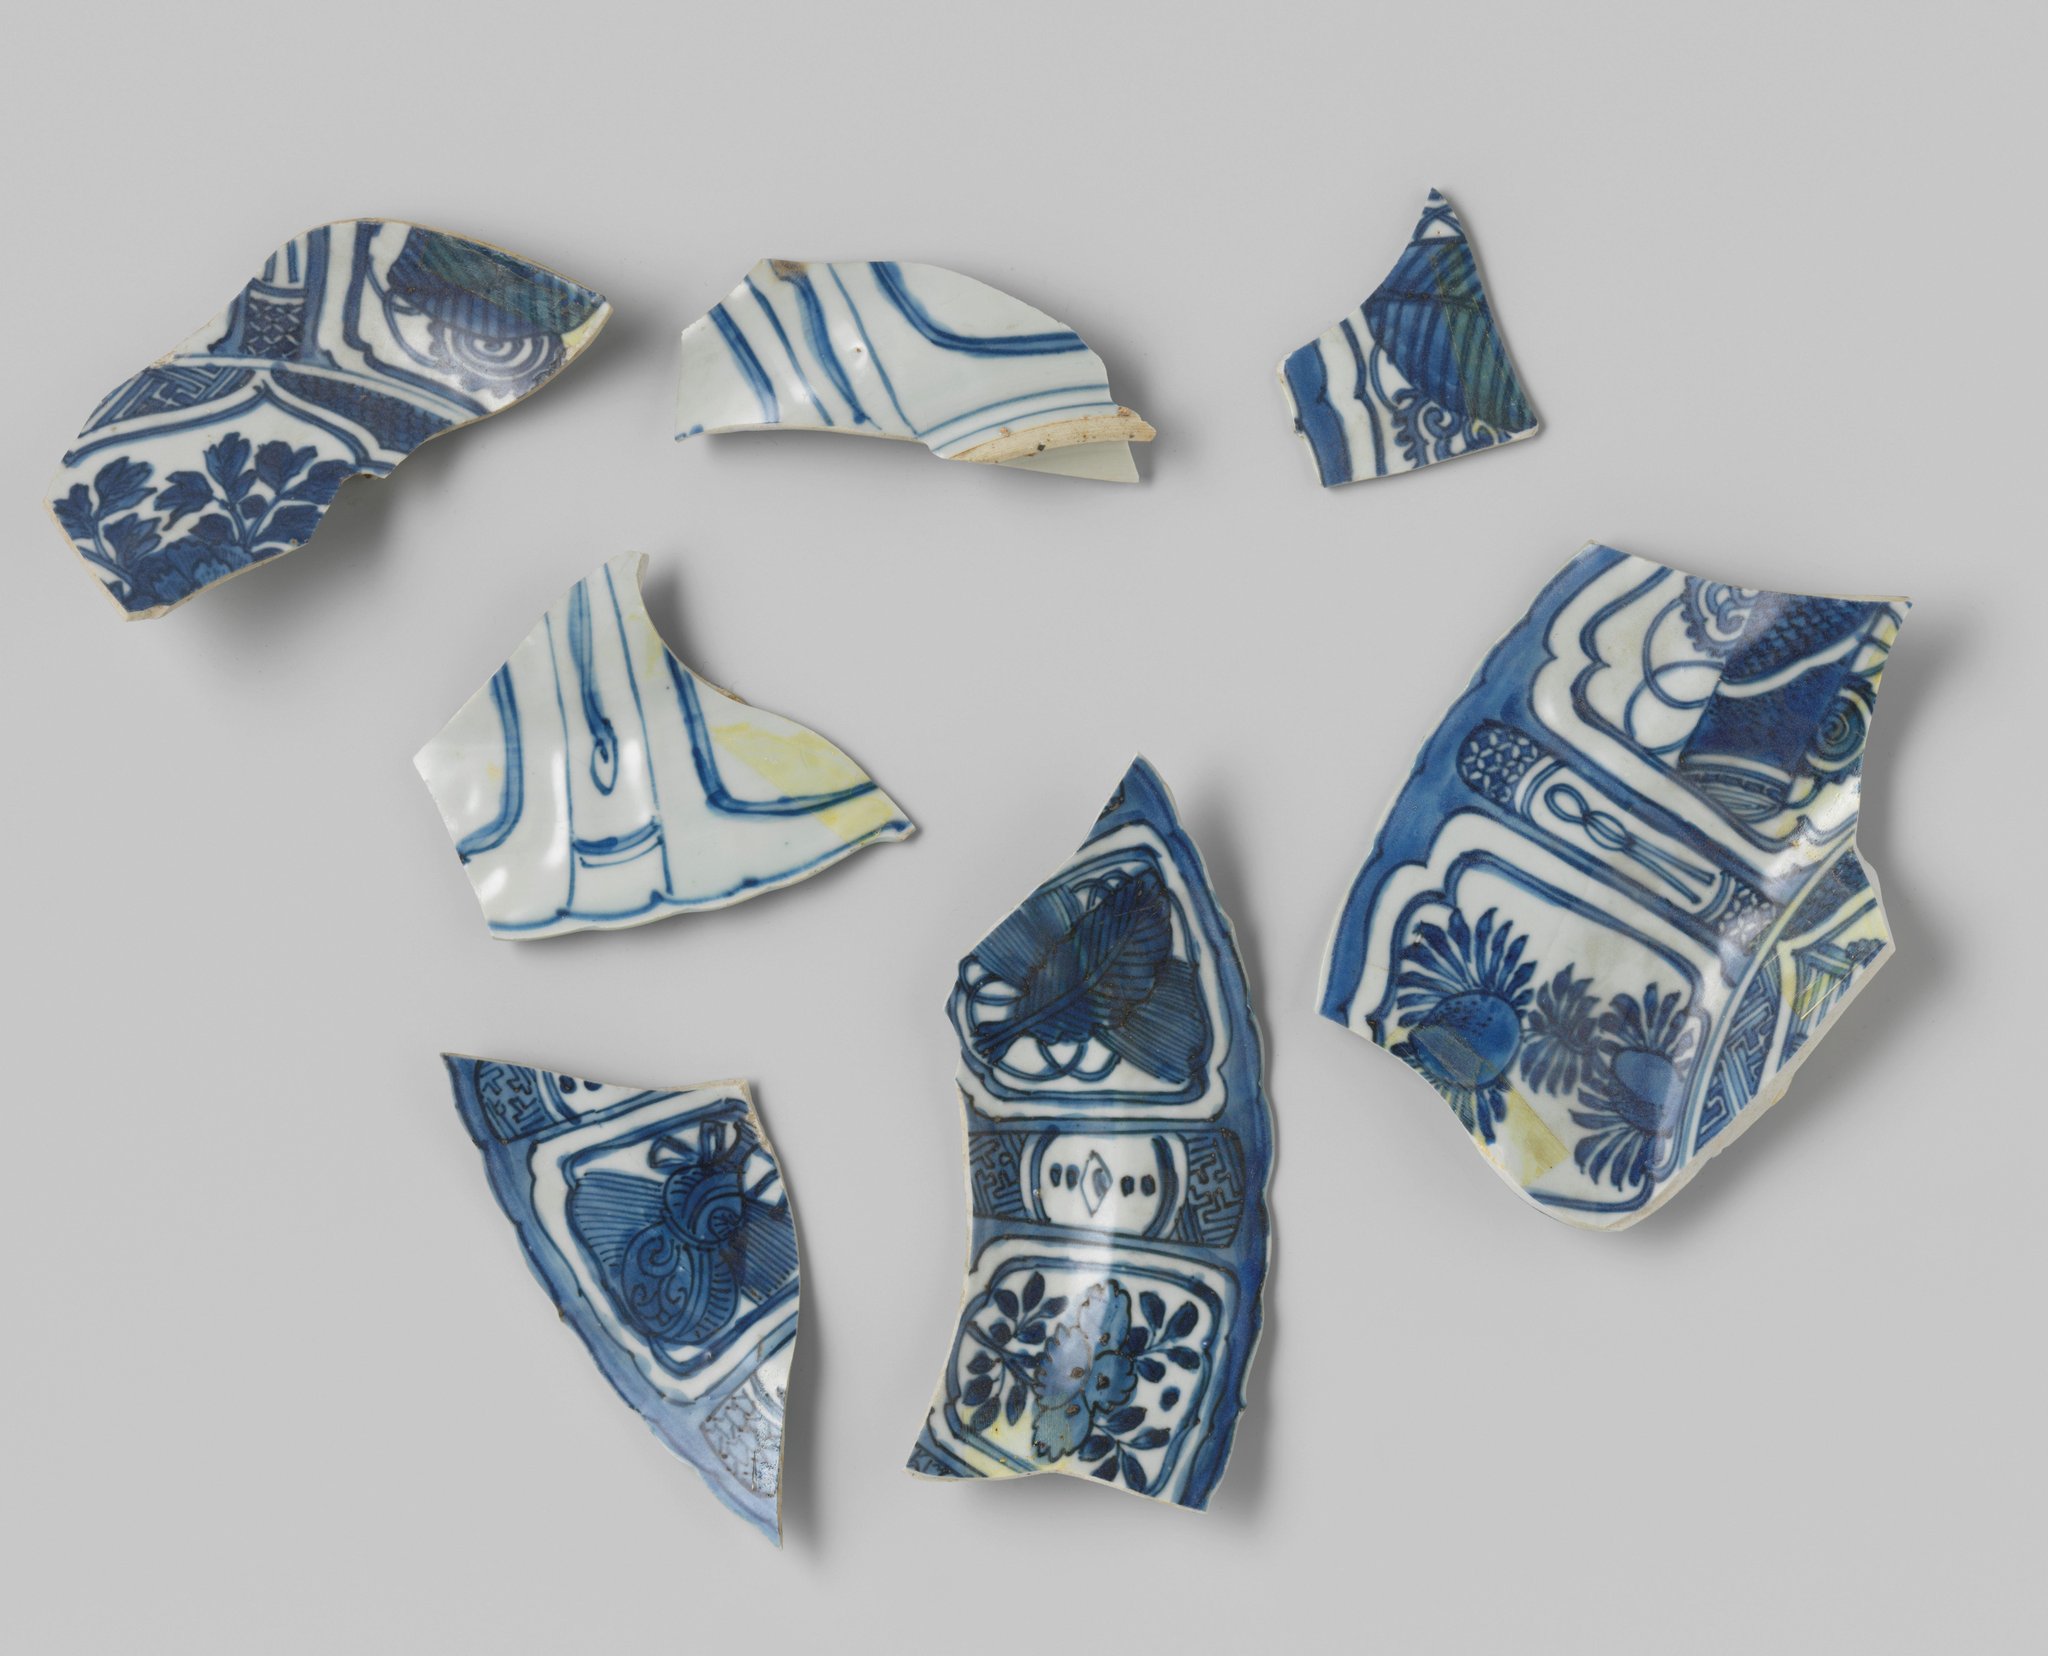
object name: sherd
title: Scherven van borden uit V.O.C.-schip de 'Witte Leeuw'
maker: Anonymous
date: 1613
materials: bone china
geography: jingdezhen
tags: verenigde oostindische compagnie, sint-helena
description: Scherven van borden uit V.O.C.-schip de 'Witte Leeuw' van kraakporselein.